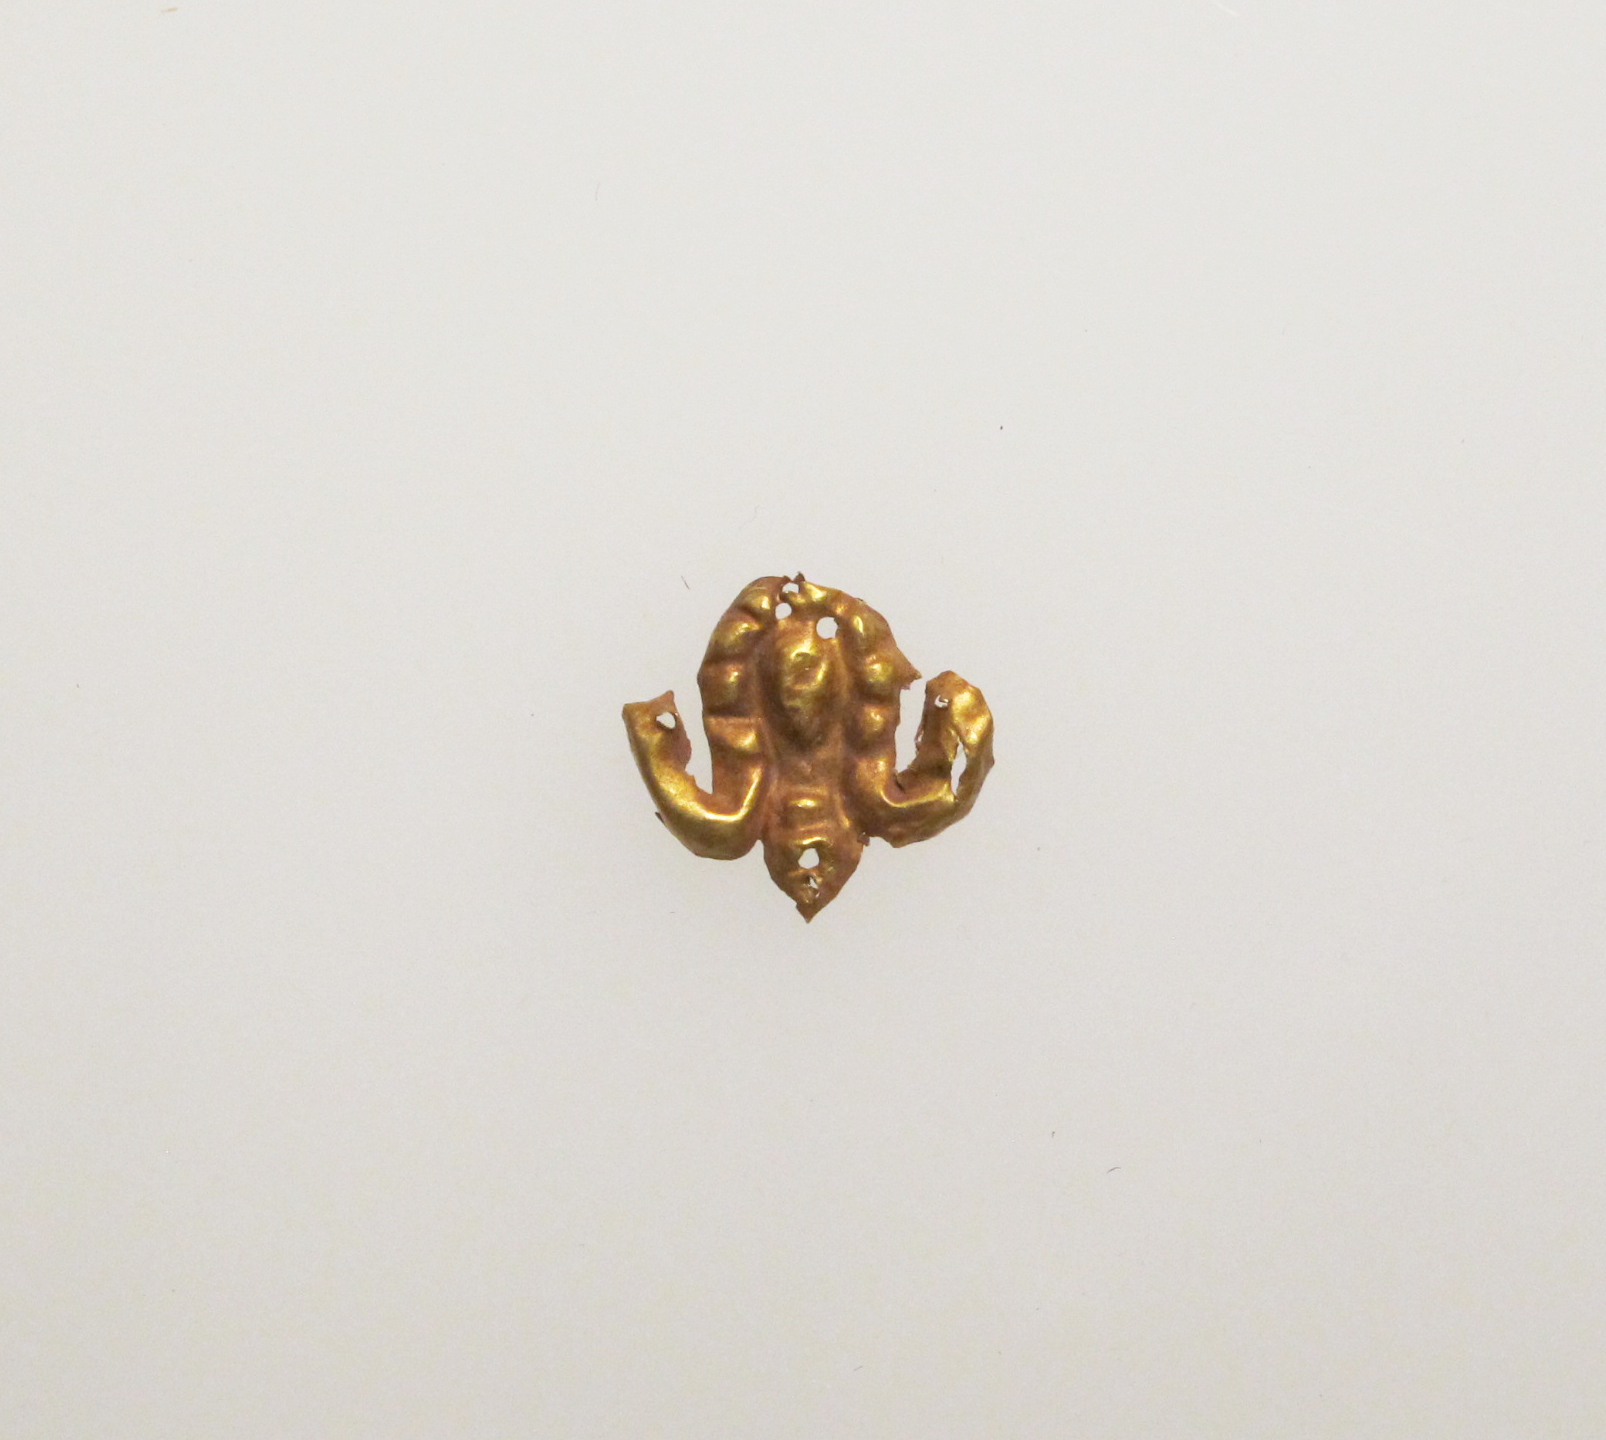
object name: bead ornament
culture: roman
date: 201-300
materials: gold